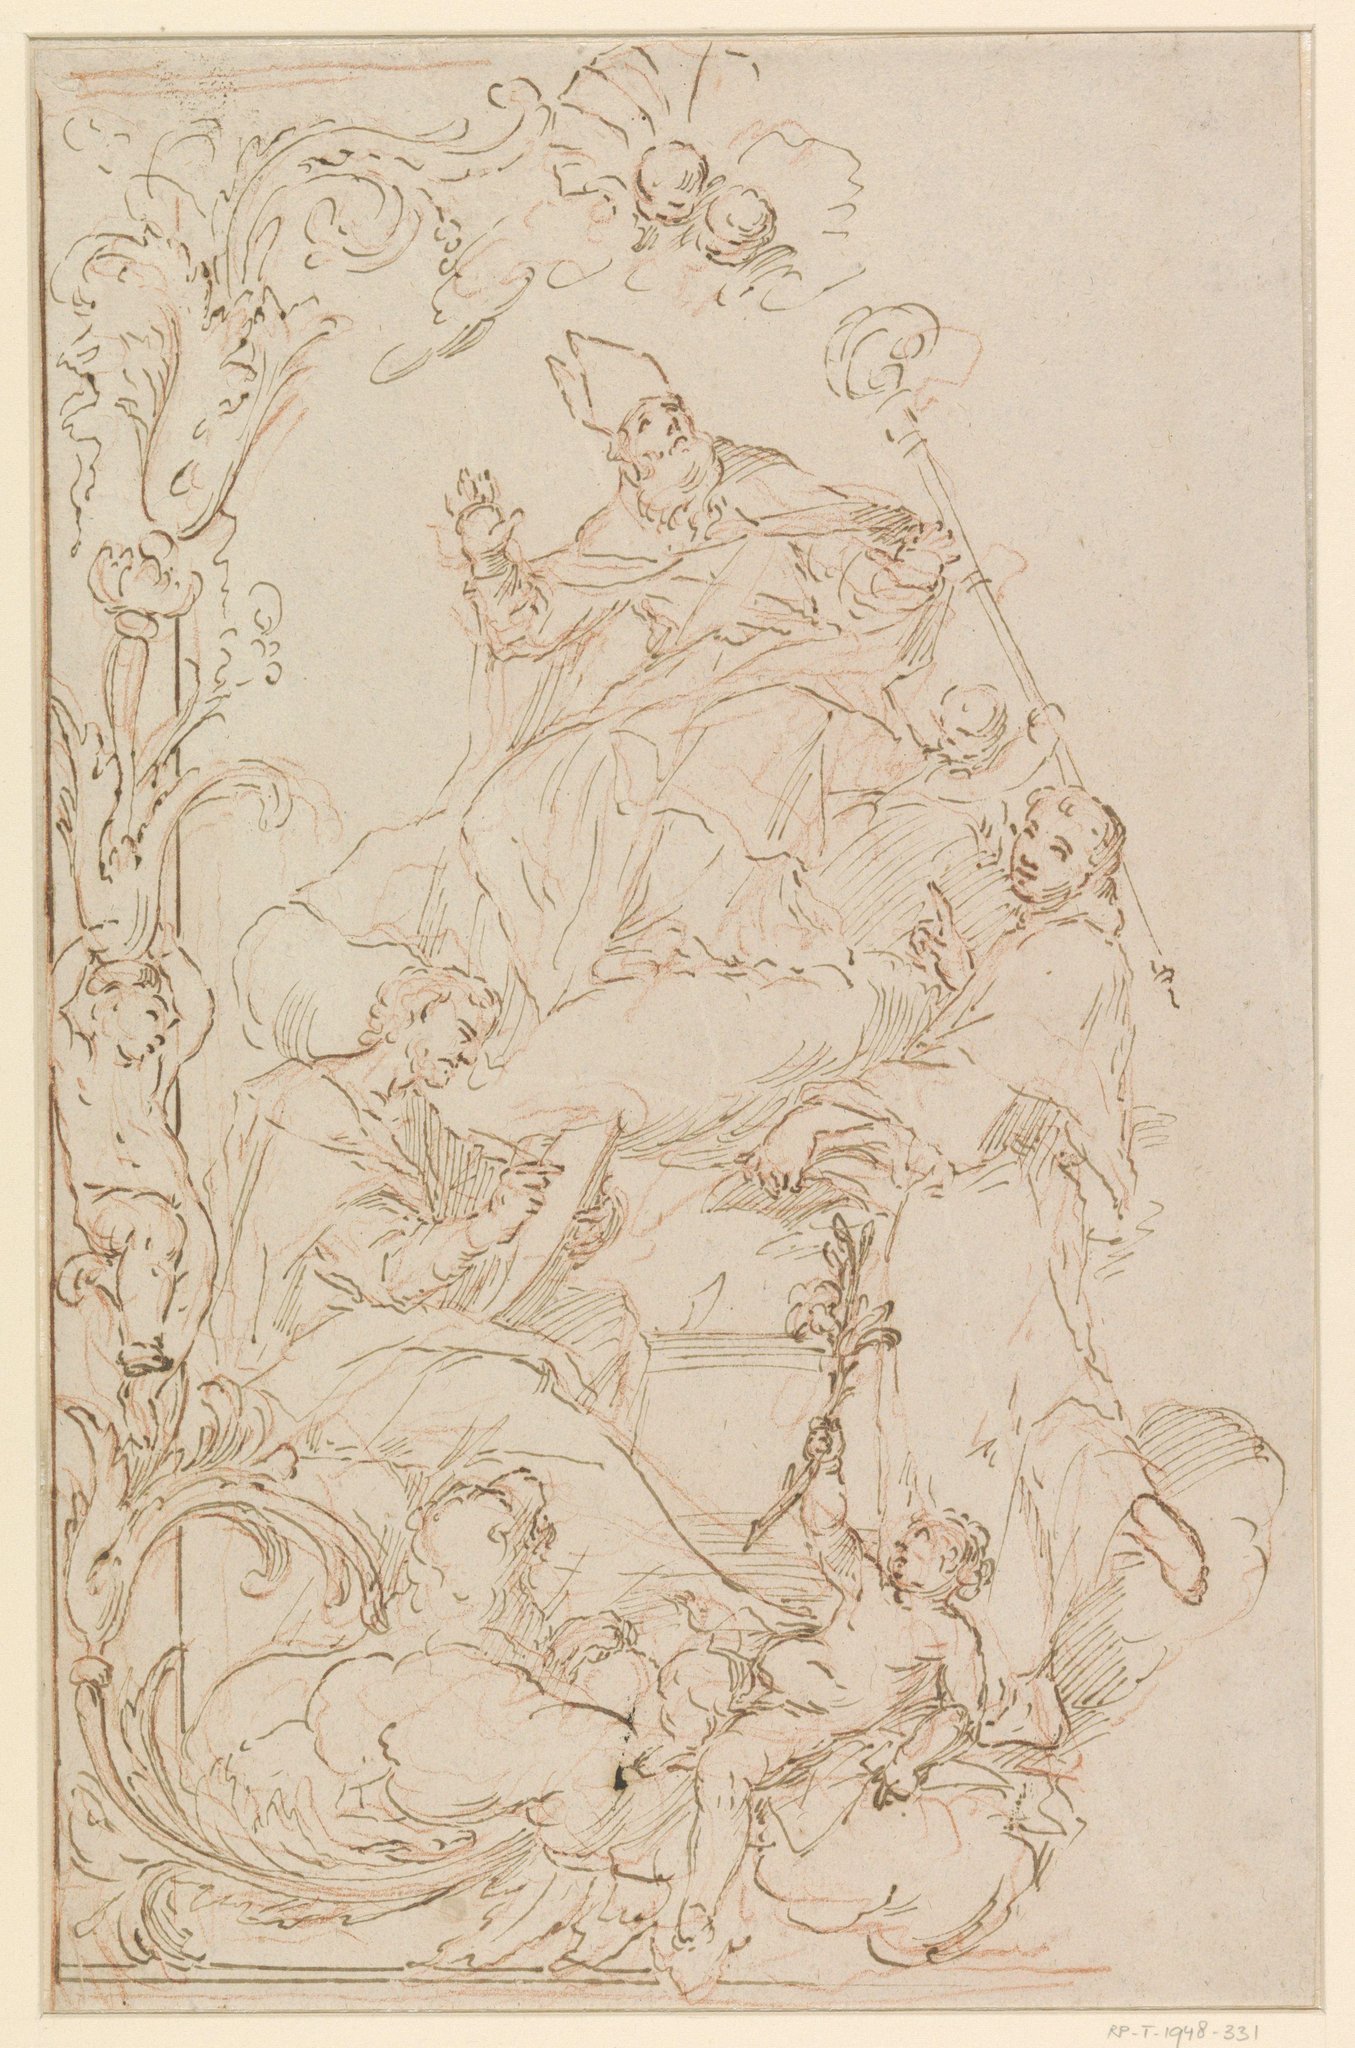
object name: design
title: Heilige bisschop met aan zijn voeten de evangelist Marcus en een staande heilige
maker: santipiatte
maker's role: draughtsman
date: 1700-1800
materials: chalk, ink, paper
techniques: pen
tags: archbishop, bishop, etc. (roman catholic), st. mark the evangelist writing the gospel, usually a (winged) lion present, male saints (with name)